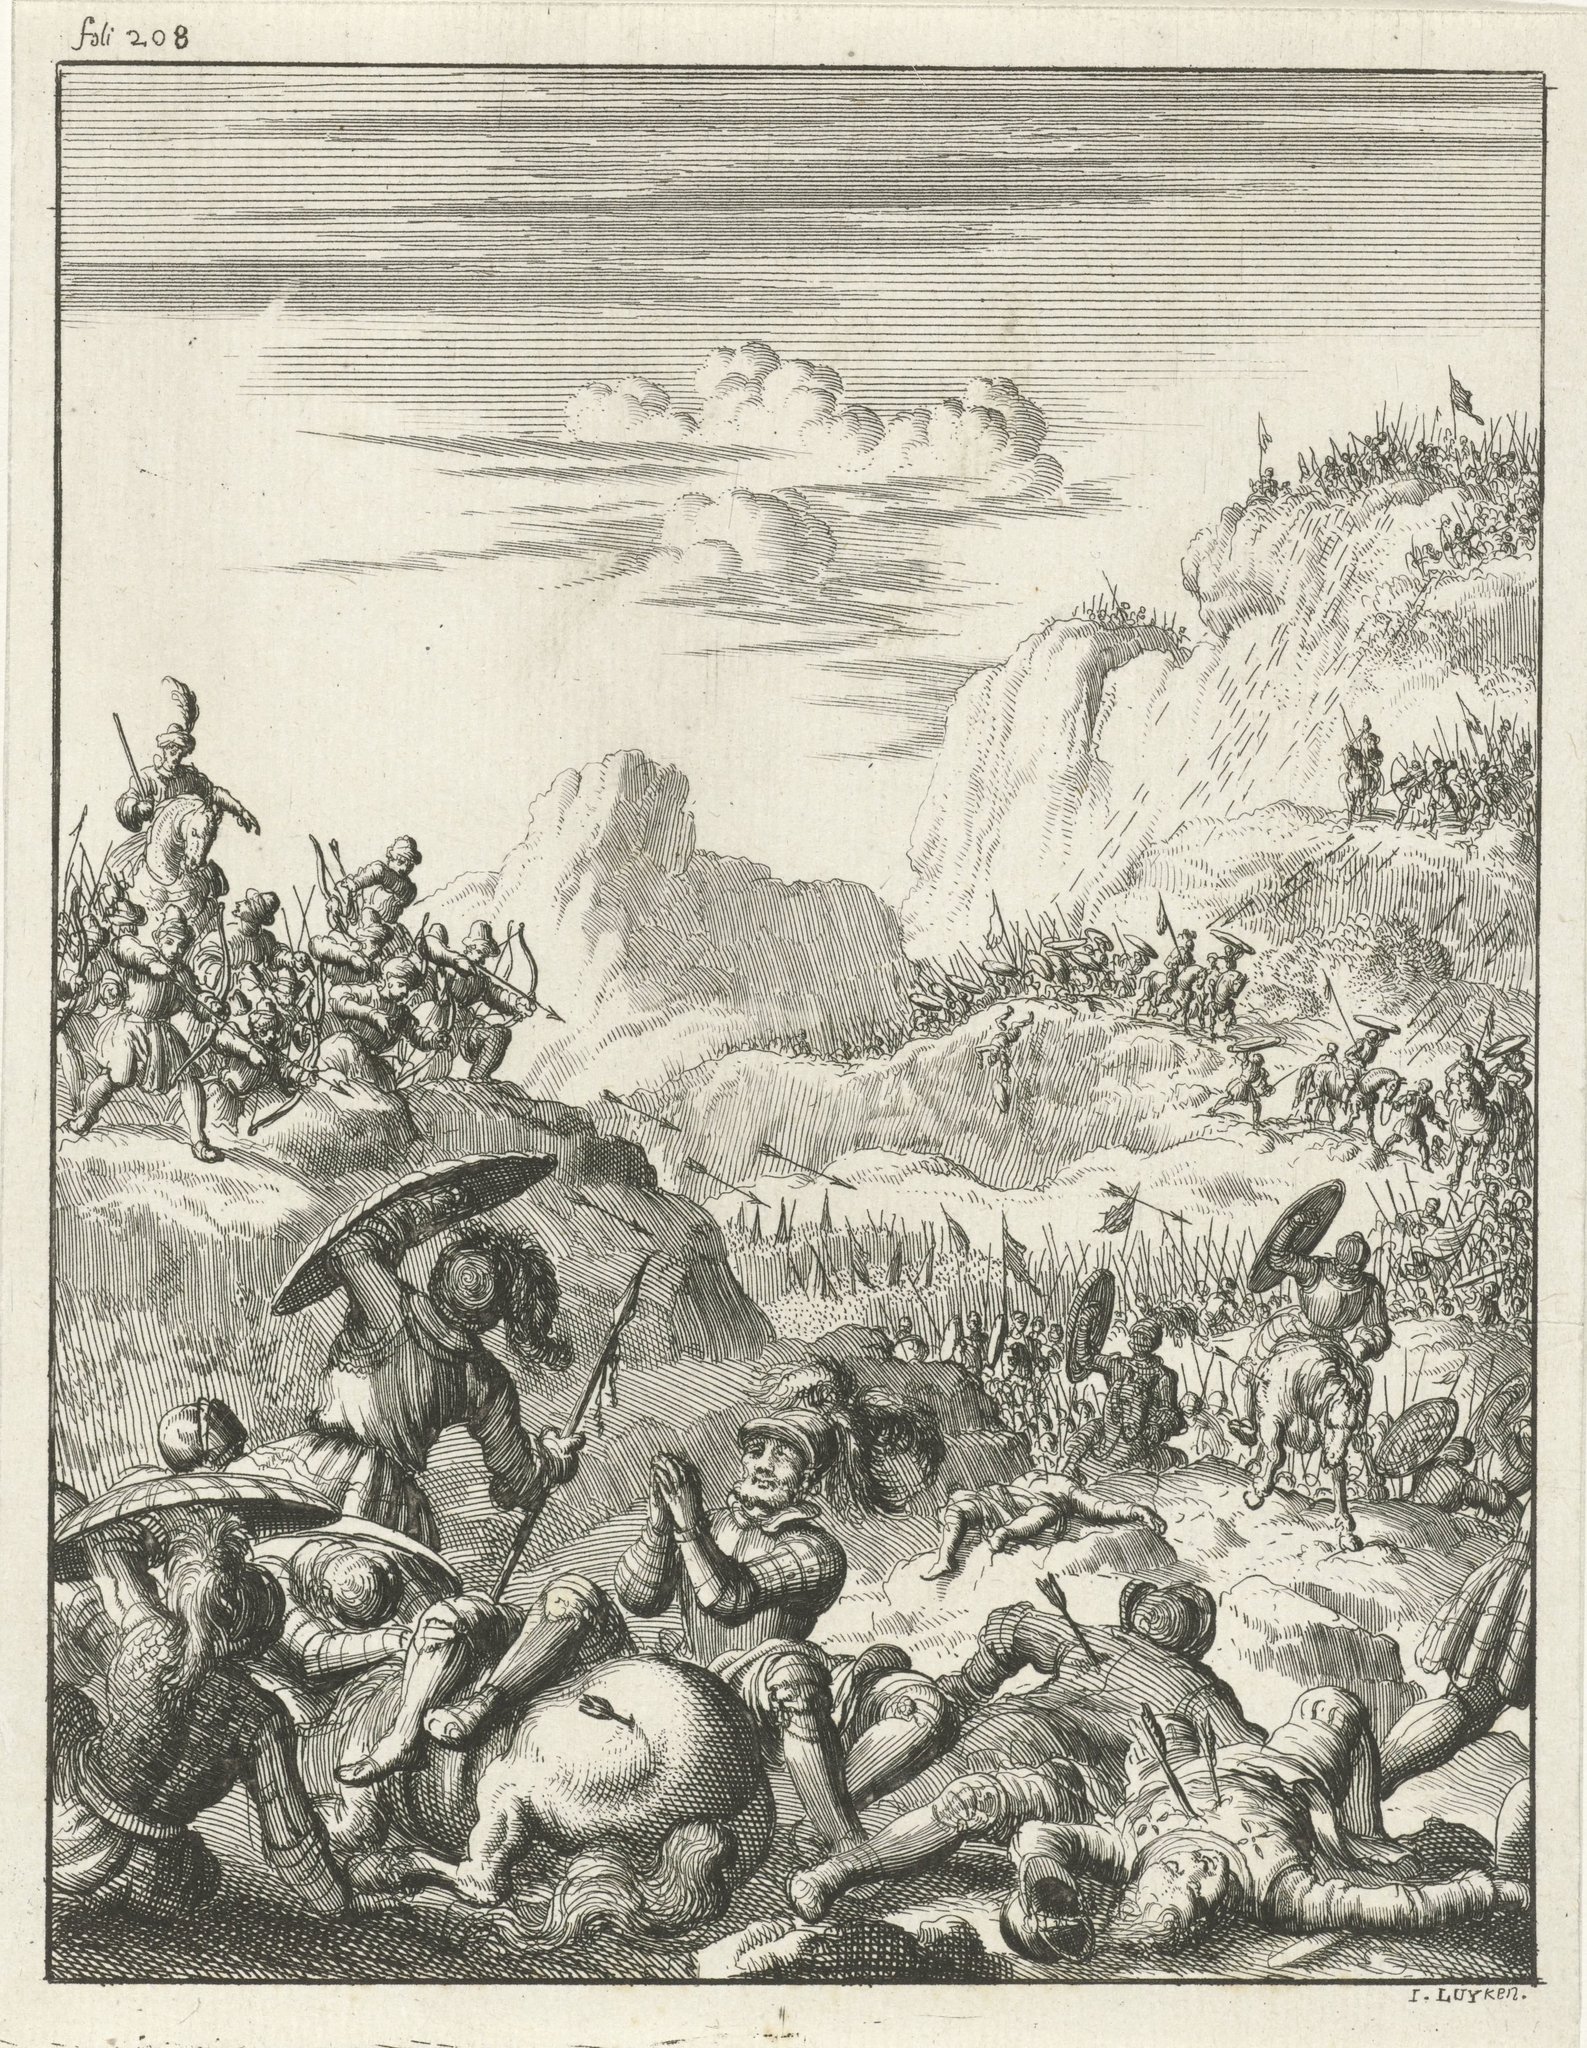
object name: book illustration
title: Leger van keizer Koenraad III verraden en in de bergen door de Saracenen overvallen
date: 1683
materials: paper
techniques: etching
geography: amsterdam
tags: militant proselytizing: religious war, crusade, etc., surprise attack (stratagem)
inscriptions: collector's mark: Lugt 2228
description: Illustratie opgenomen in: Maimbourg, Louis. Historie der kruisvaarders, tot de verlossing van't heilig land. Amsterdam: Timotheus ten Hoorn, 1683.